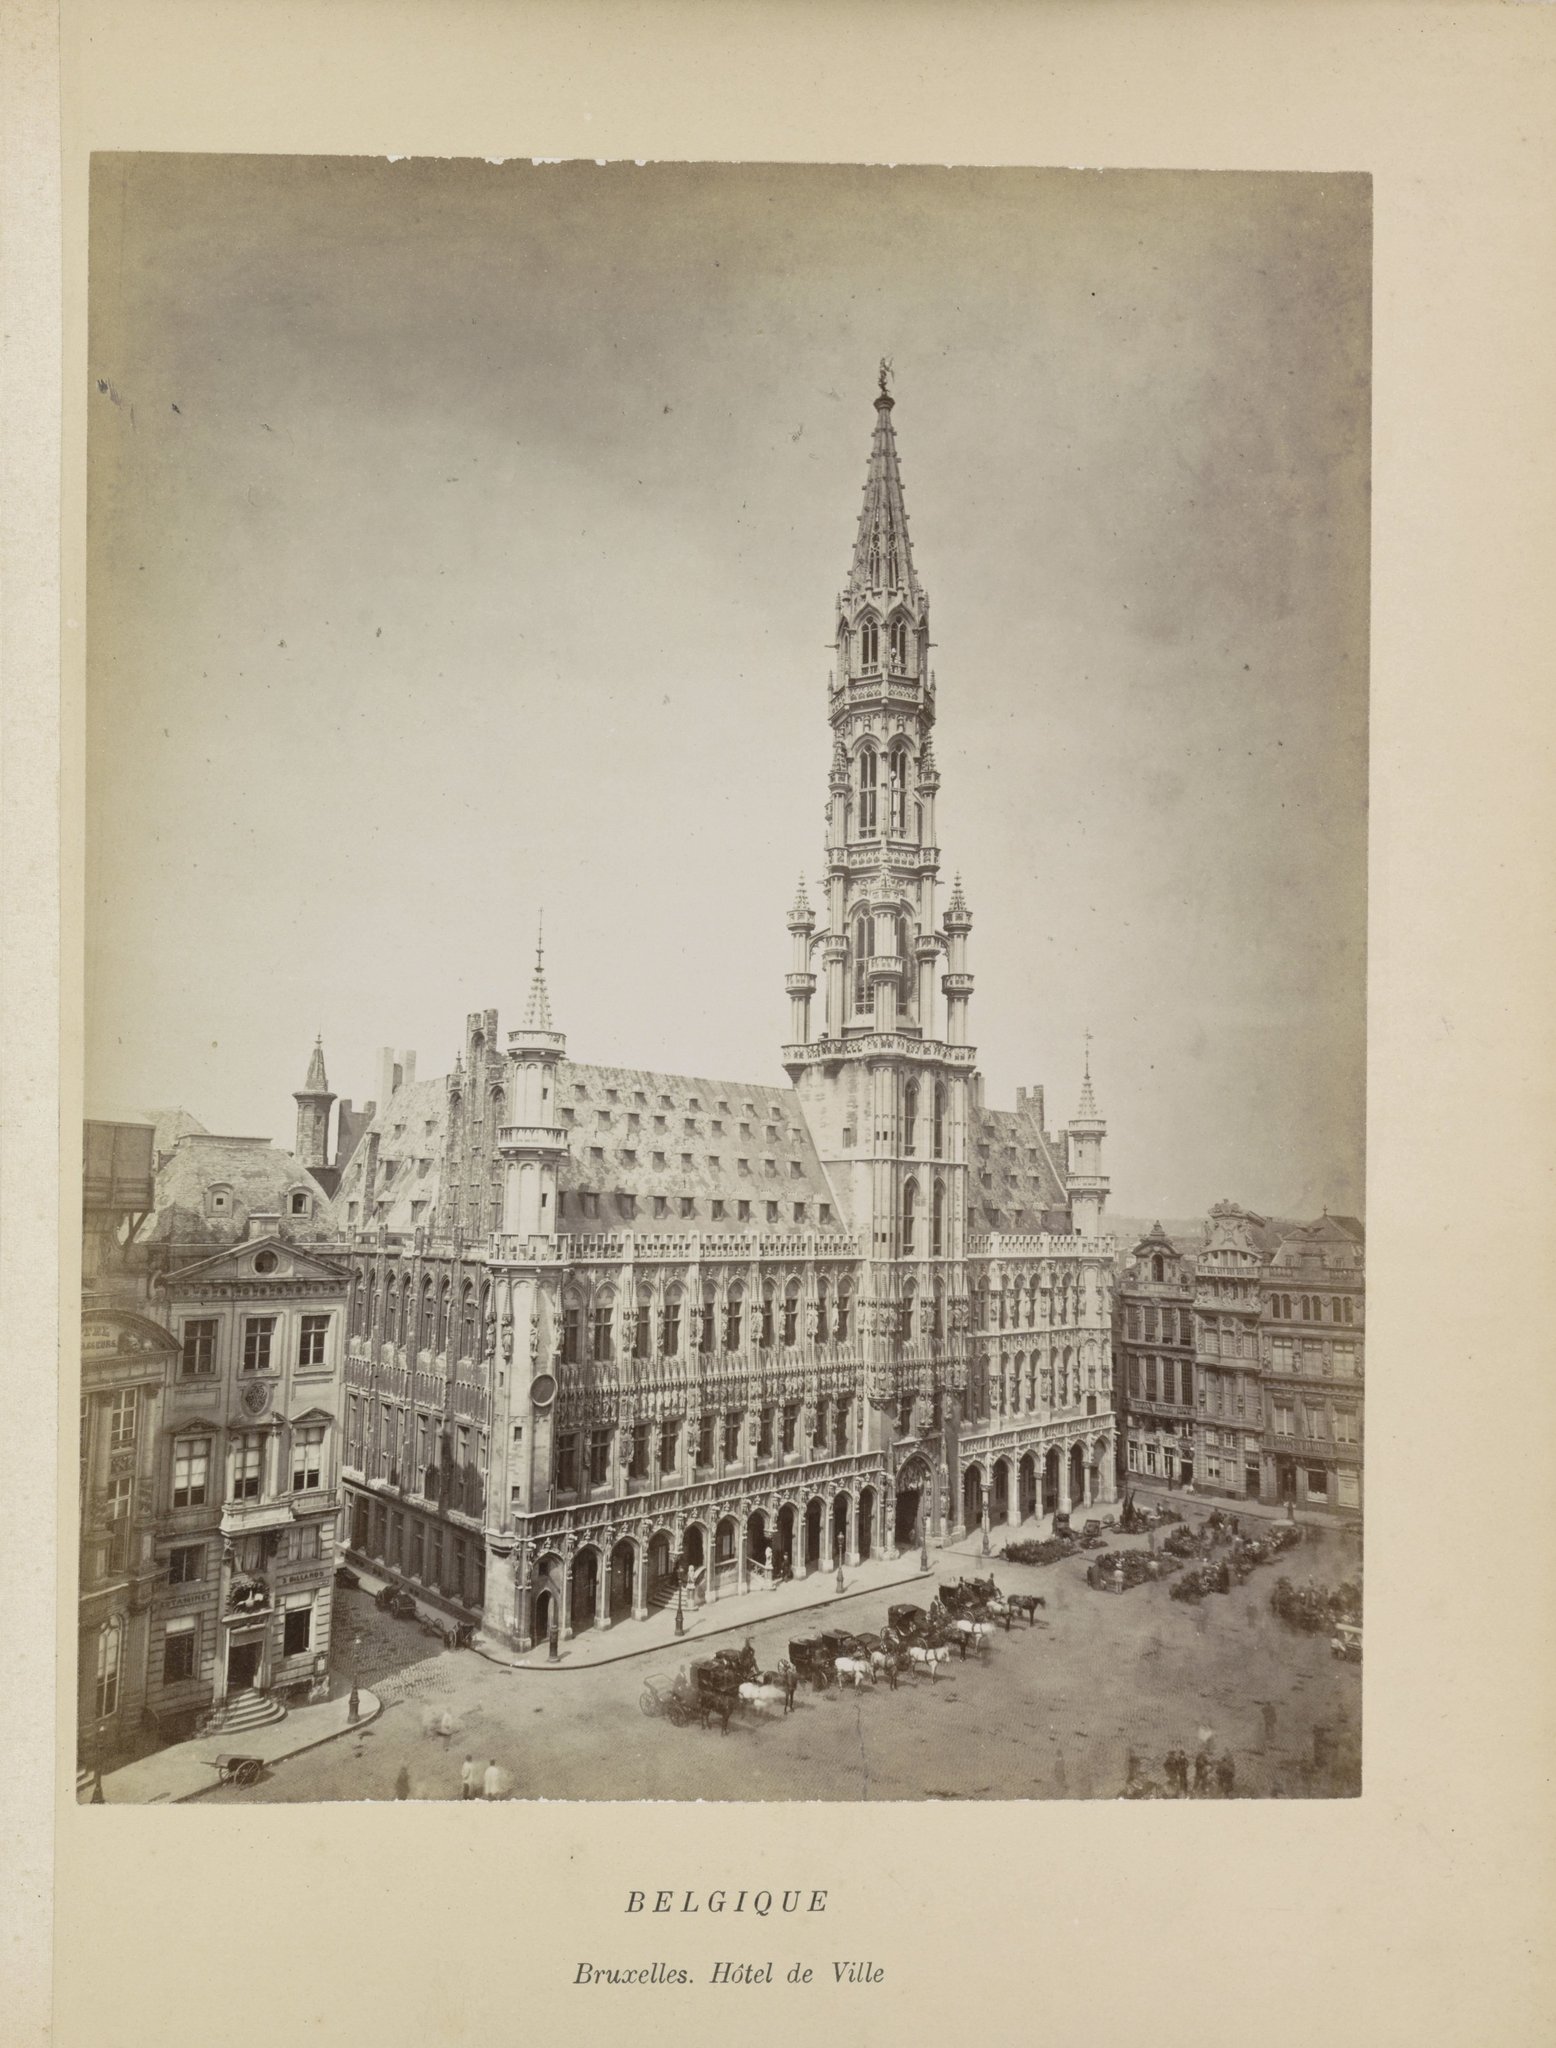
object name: photograph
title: Belgique / Bruxelles. Hôtel de Ville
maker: Anonymous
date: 1885-1900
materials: paper, photographic support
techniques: albumen print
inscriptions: caption: ‘Belgique / Bruxelles. Hôtel de Ville’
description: Koetsen op het plein voor het Stadhuis (Hôtel de Ville) van Brussel, België